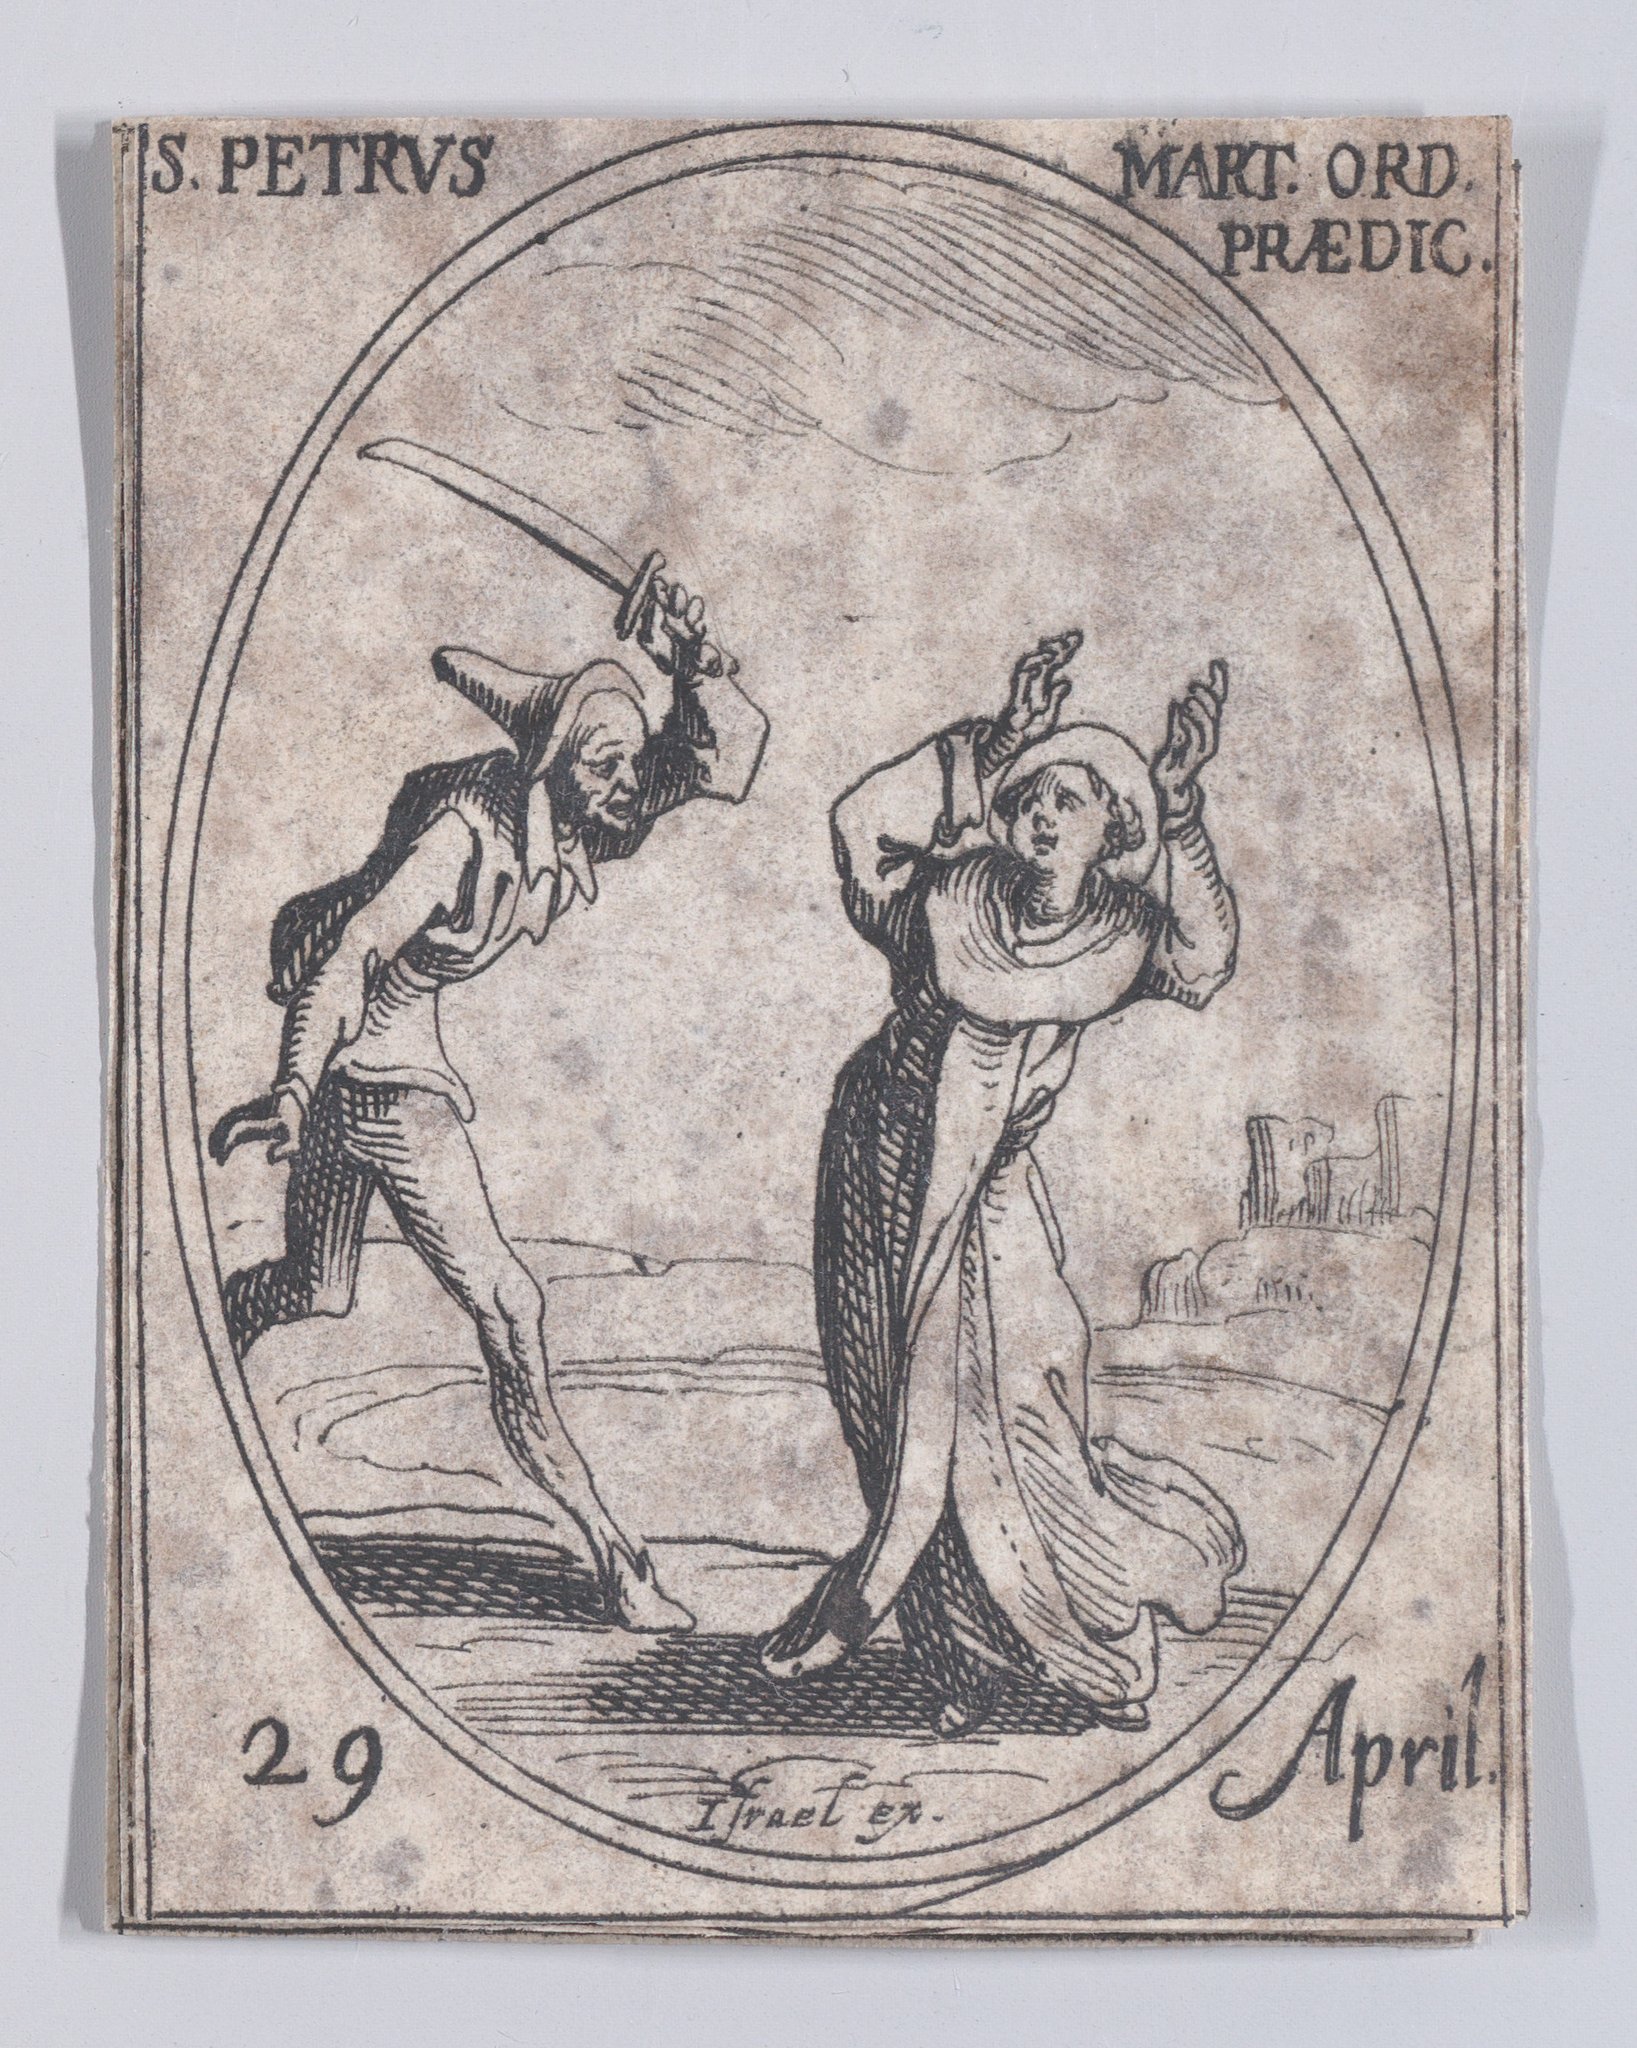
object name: print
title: S. Pierre, prédicateur (St. Peter, Preacher), April 29th, from "Les Images De Tous Les Saincts et Saintes de L'Année" (Images of All of the Saints and Religious Events of the Year)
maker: jacques callot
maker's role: artist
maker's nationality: french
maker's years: 1592-1635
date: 1636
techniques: etching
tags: men,saints